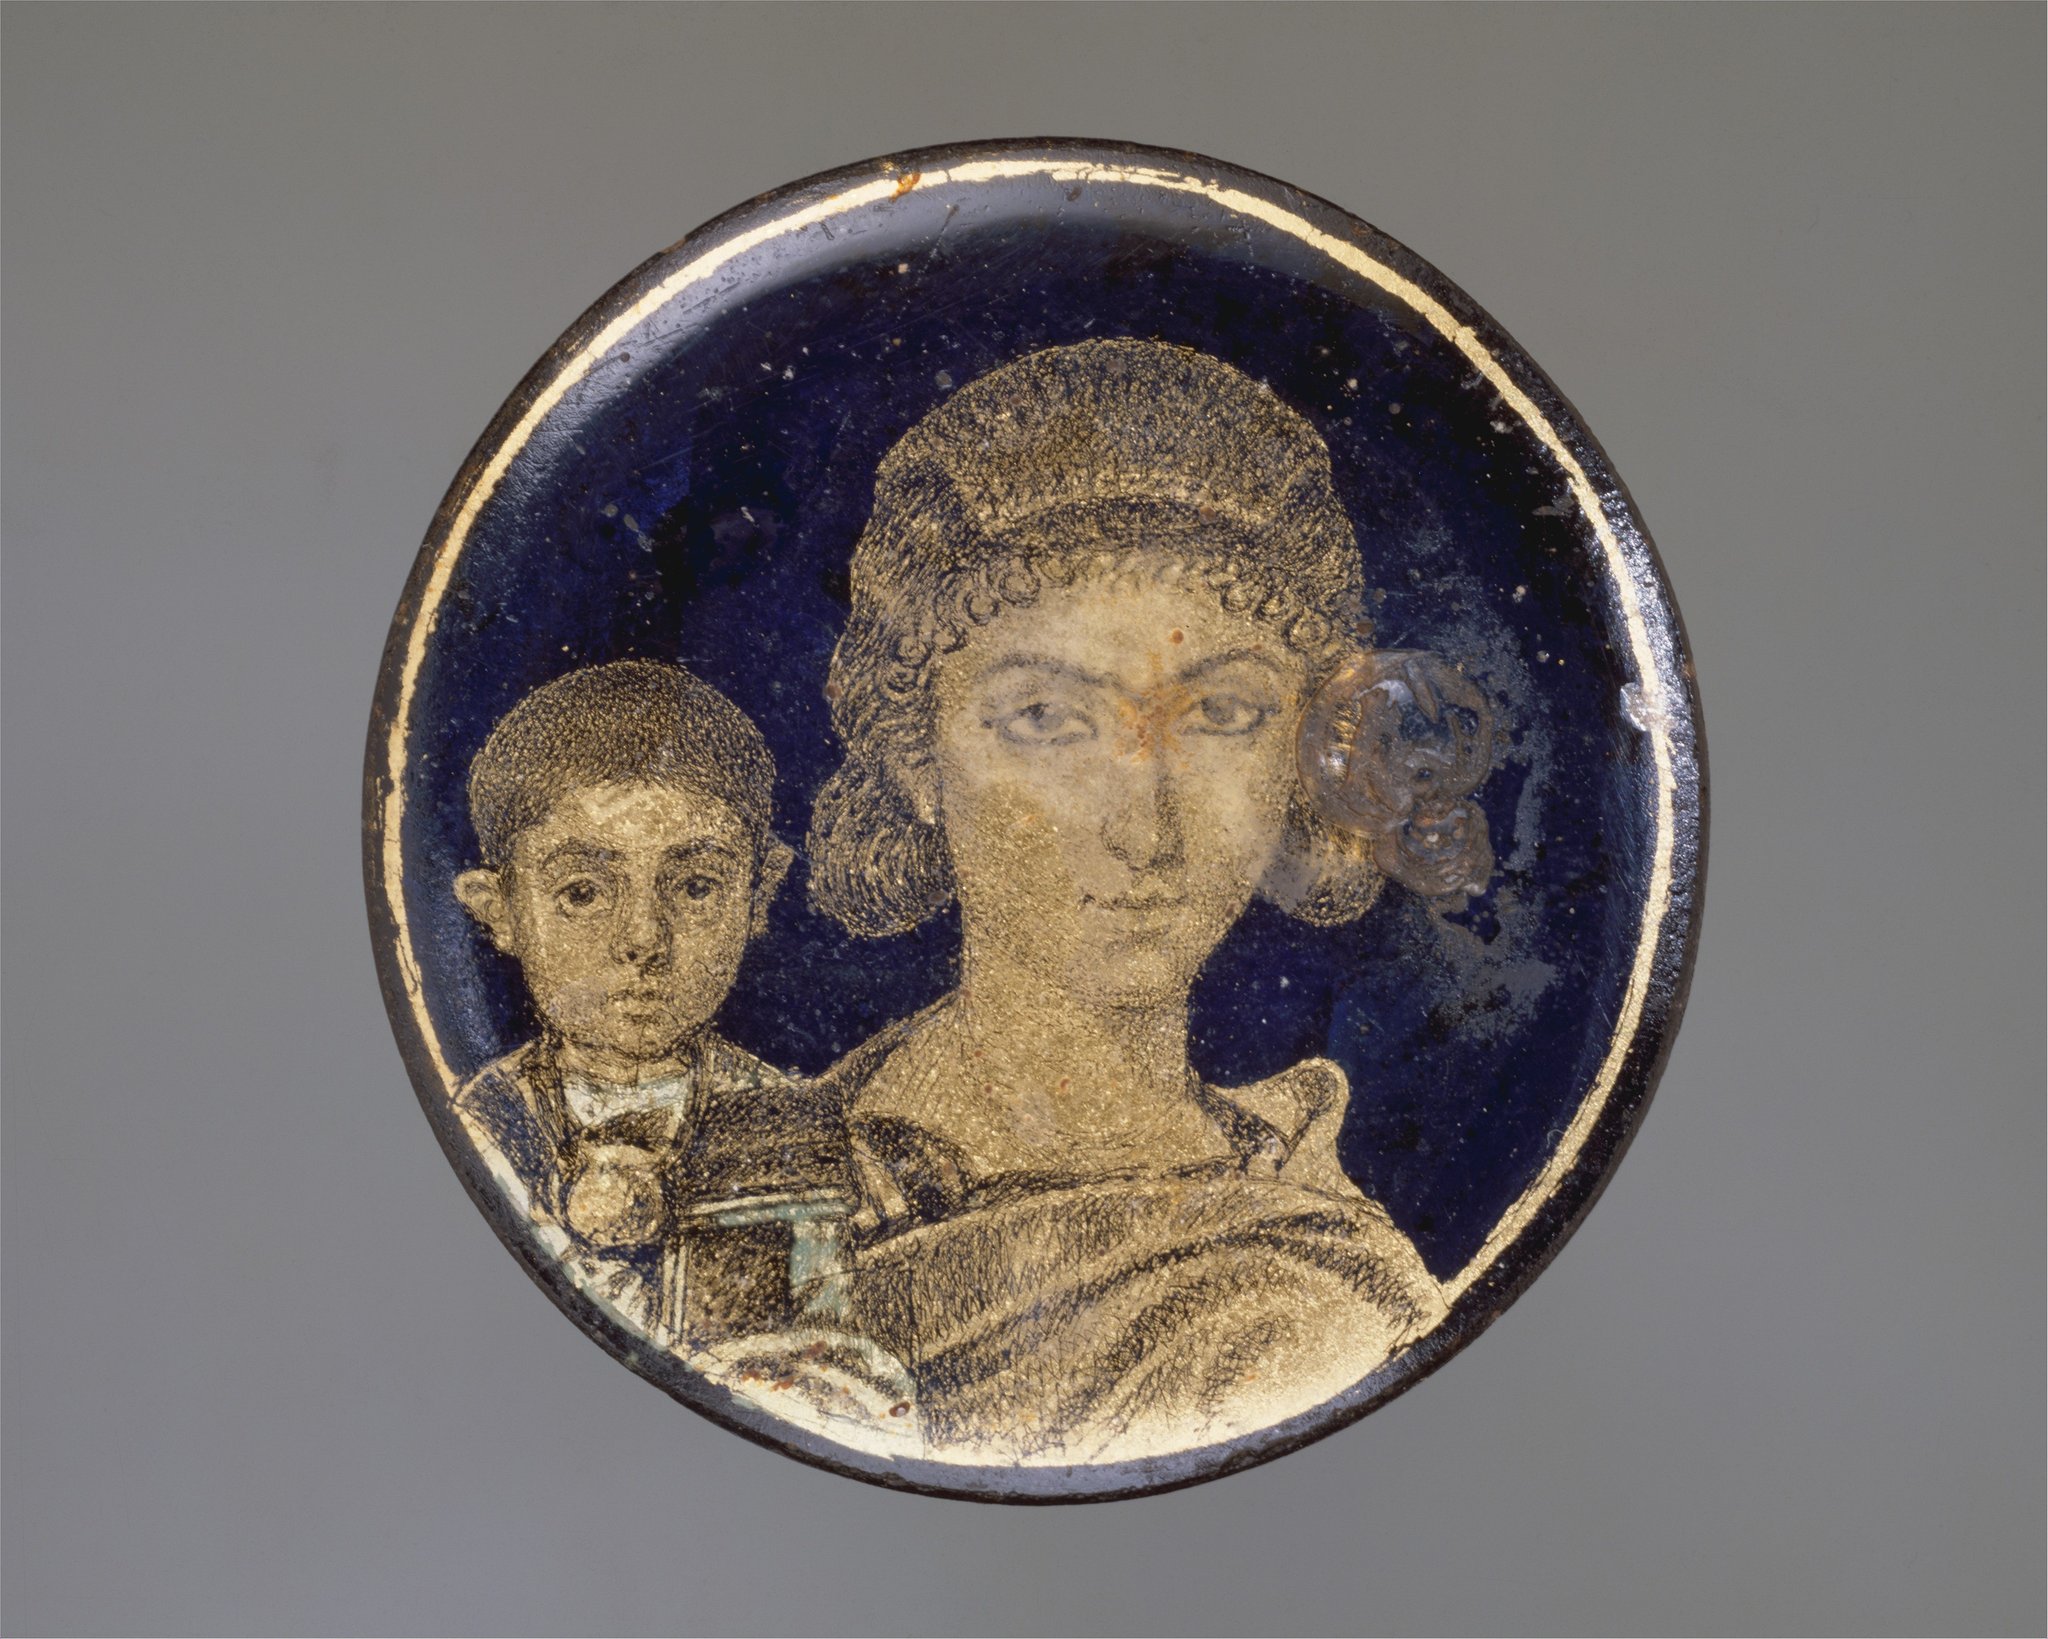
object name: medallion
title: Gold Glass Medallion with a Mother and Child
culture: roman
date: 301-333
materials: glass, gold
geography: egypt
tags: madonna and child